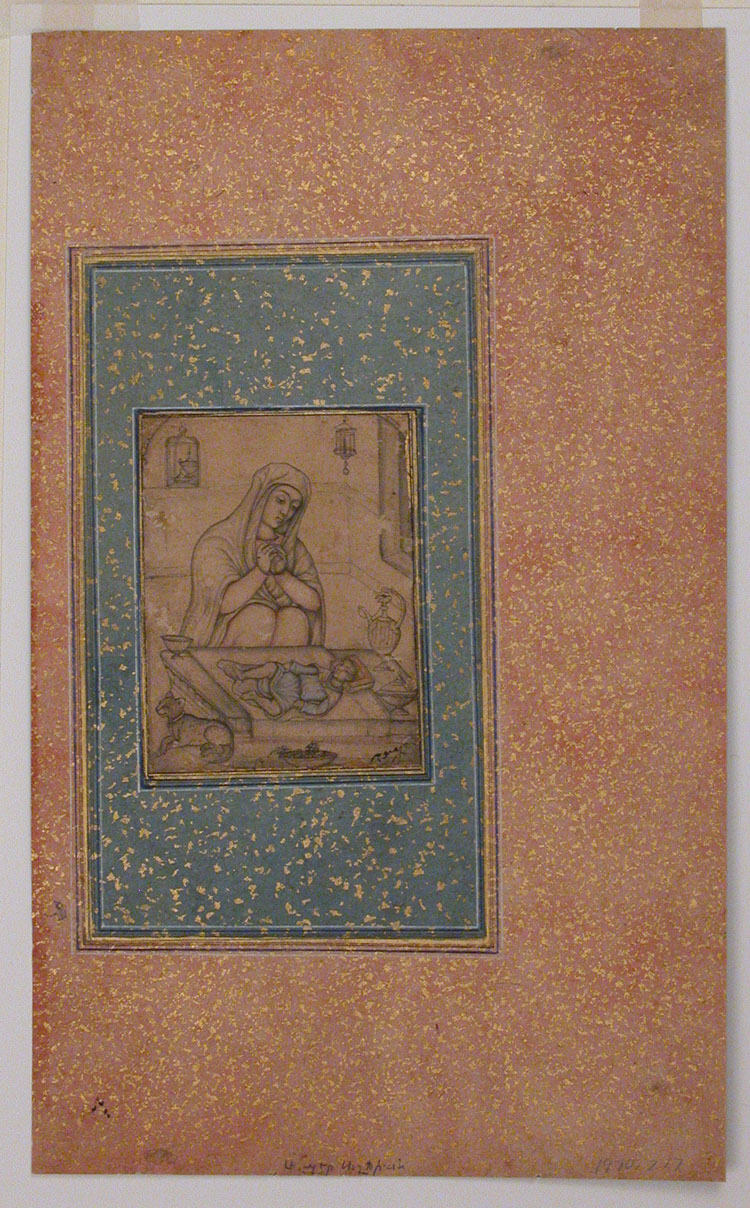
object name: illustrated single work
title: Madonna and Child in a Domestic Interior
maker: manohar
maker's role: artist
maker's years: 1577-1624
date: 1601-1633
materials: gold, ink, paper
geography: india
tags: madonna and child